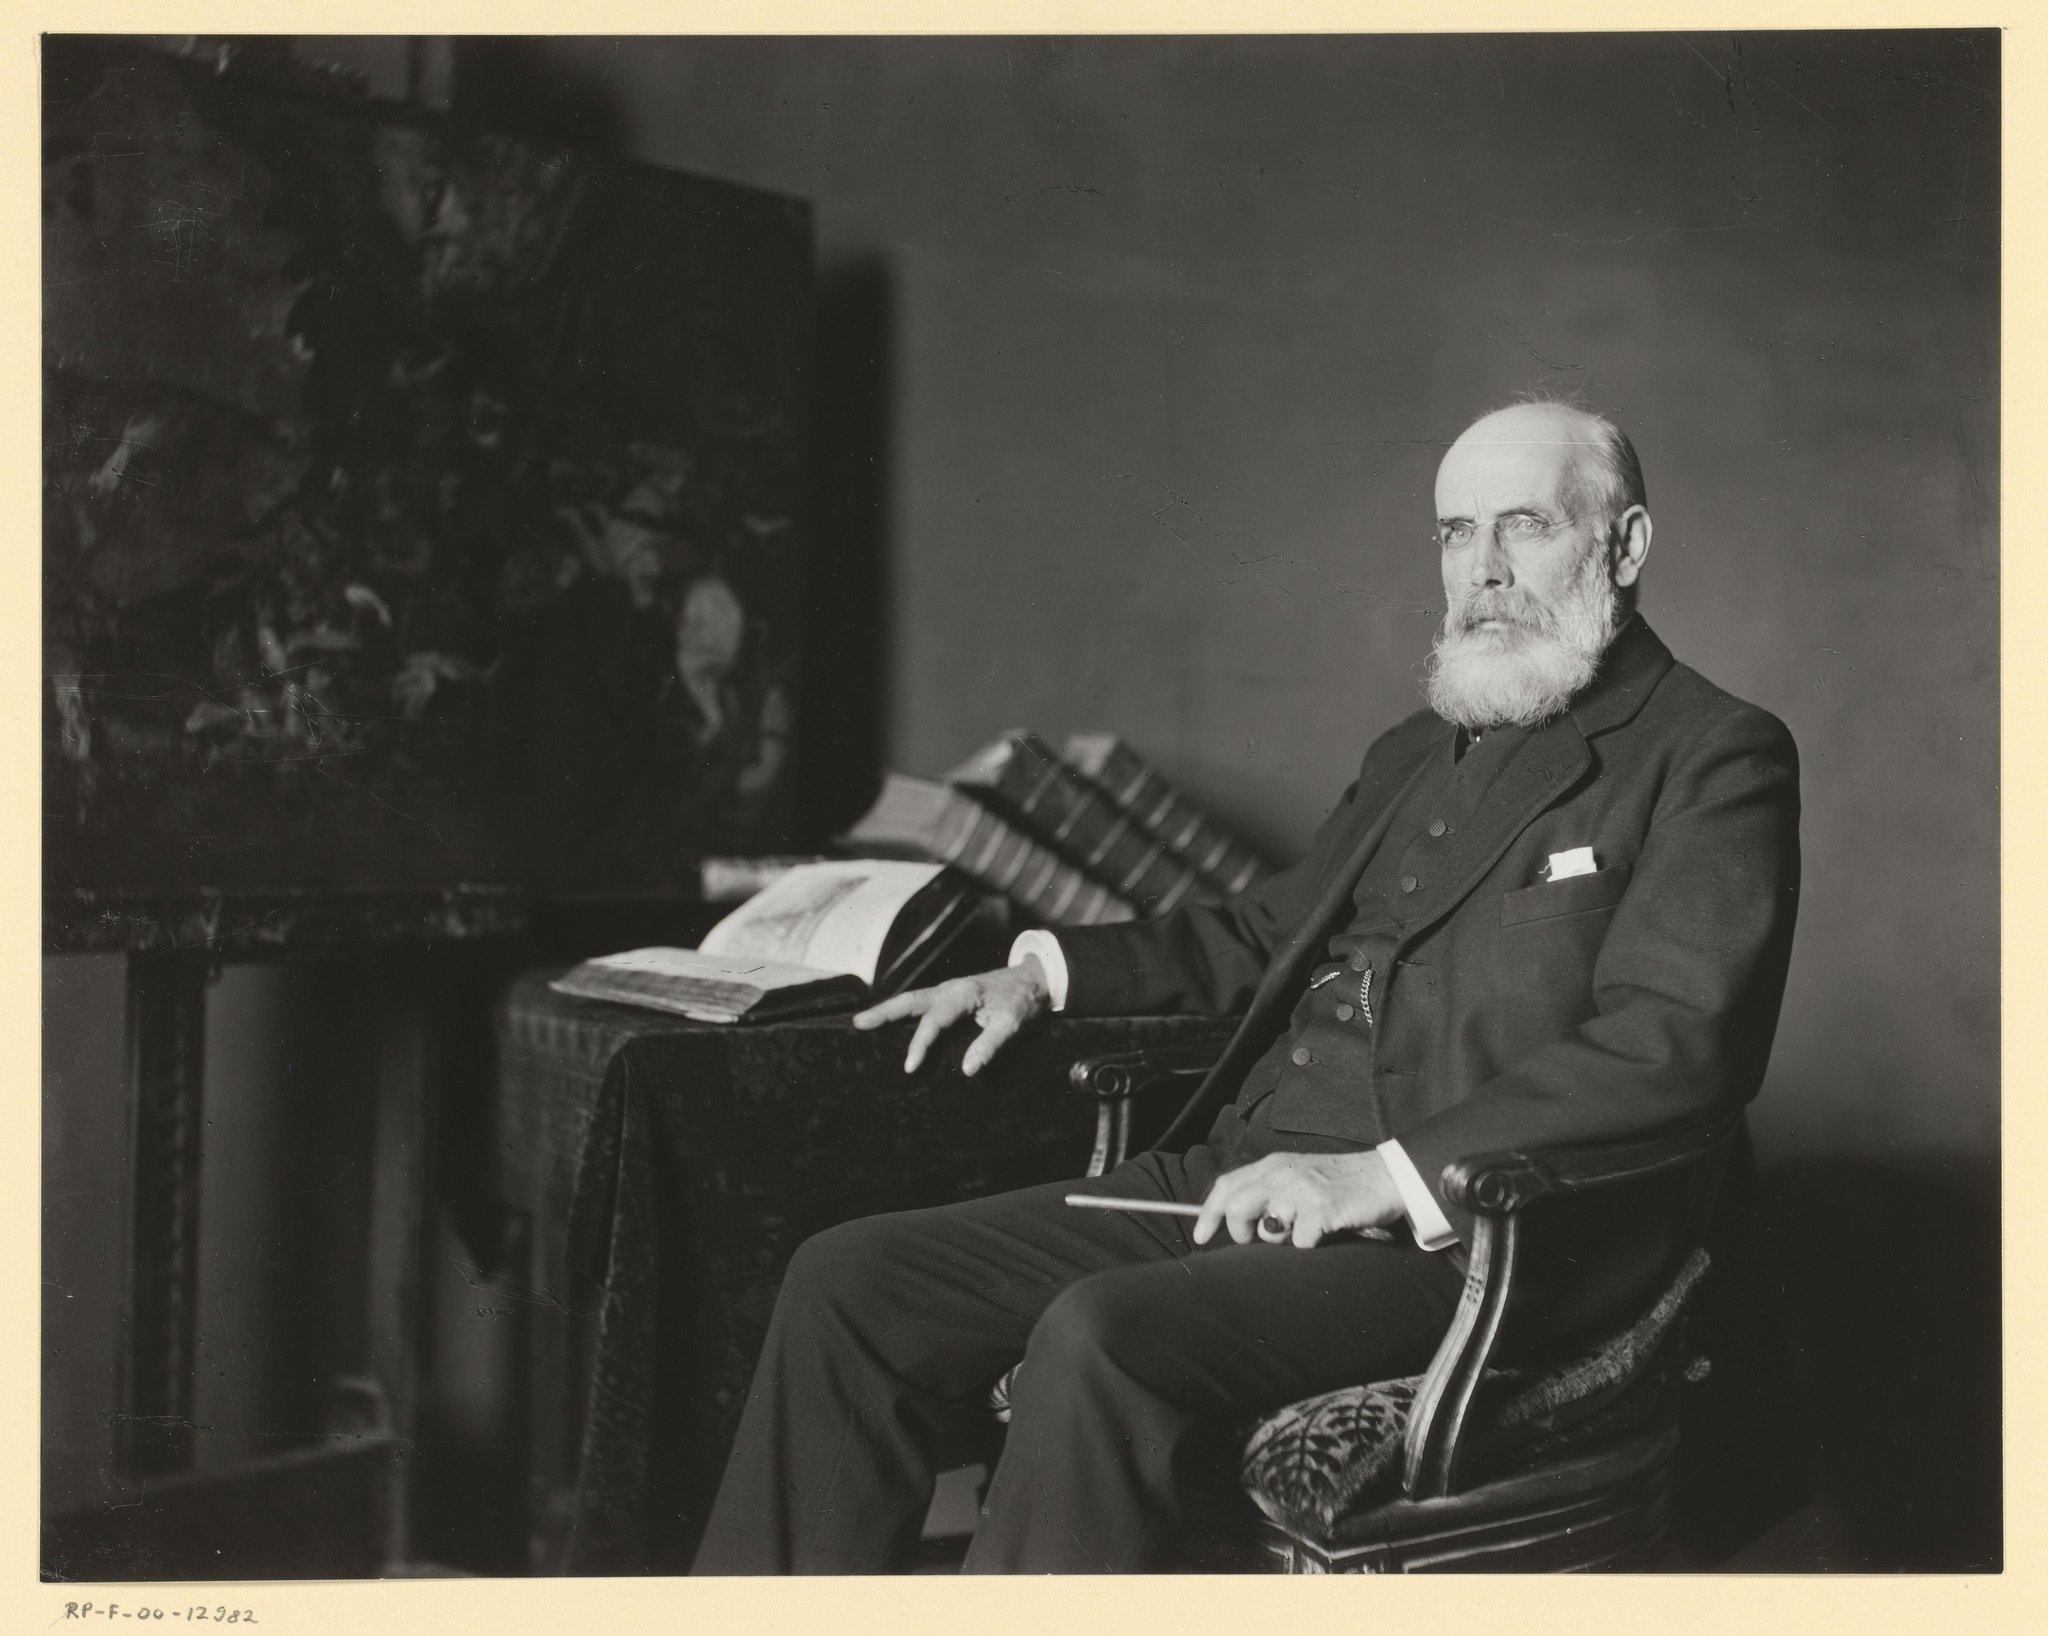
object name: photograph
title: Portret van Barthold Willem Floris van Riemsdijk, directeur van het Rijksmuseum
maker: Anonymous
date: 1920-1940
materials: paper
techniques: gelatin silver print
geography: amsterdam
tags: maastricht, amsterdam, print maker, engineer, jonkheer barthold willem floris van riemsdijk, historical persons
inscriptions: number: ‘636’, stamp: ‘Foto/ Rijksmuseum/ Amsterdam’